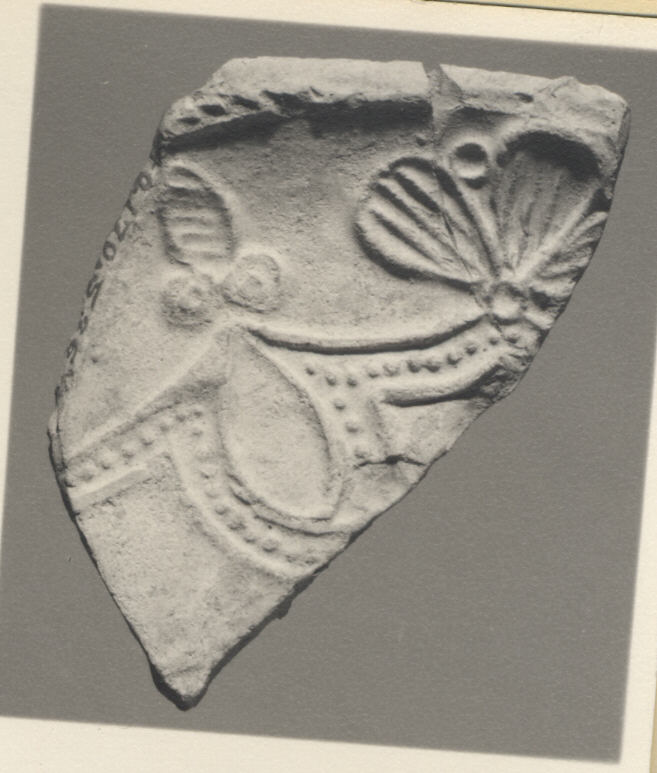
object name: fragment of a dish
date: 701-900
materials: earthenware, engobe, glaze, gold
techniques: molding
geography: iran